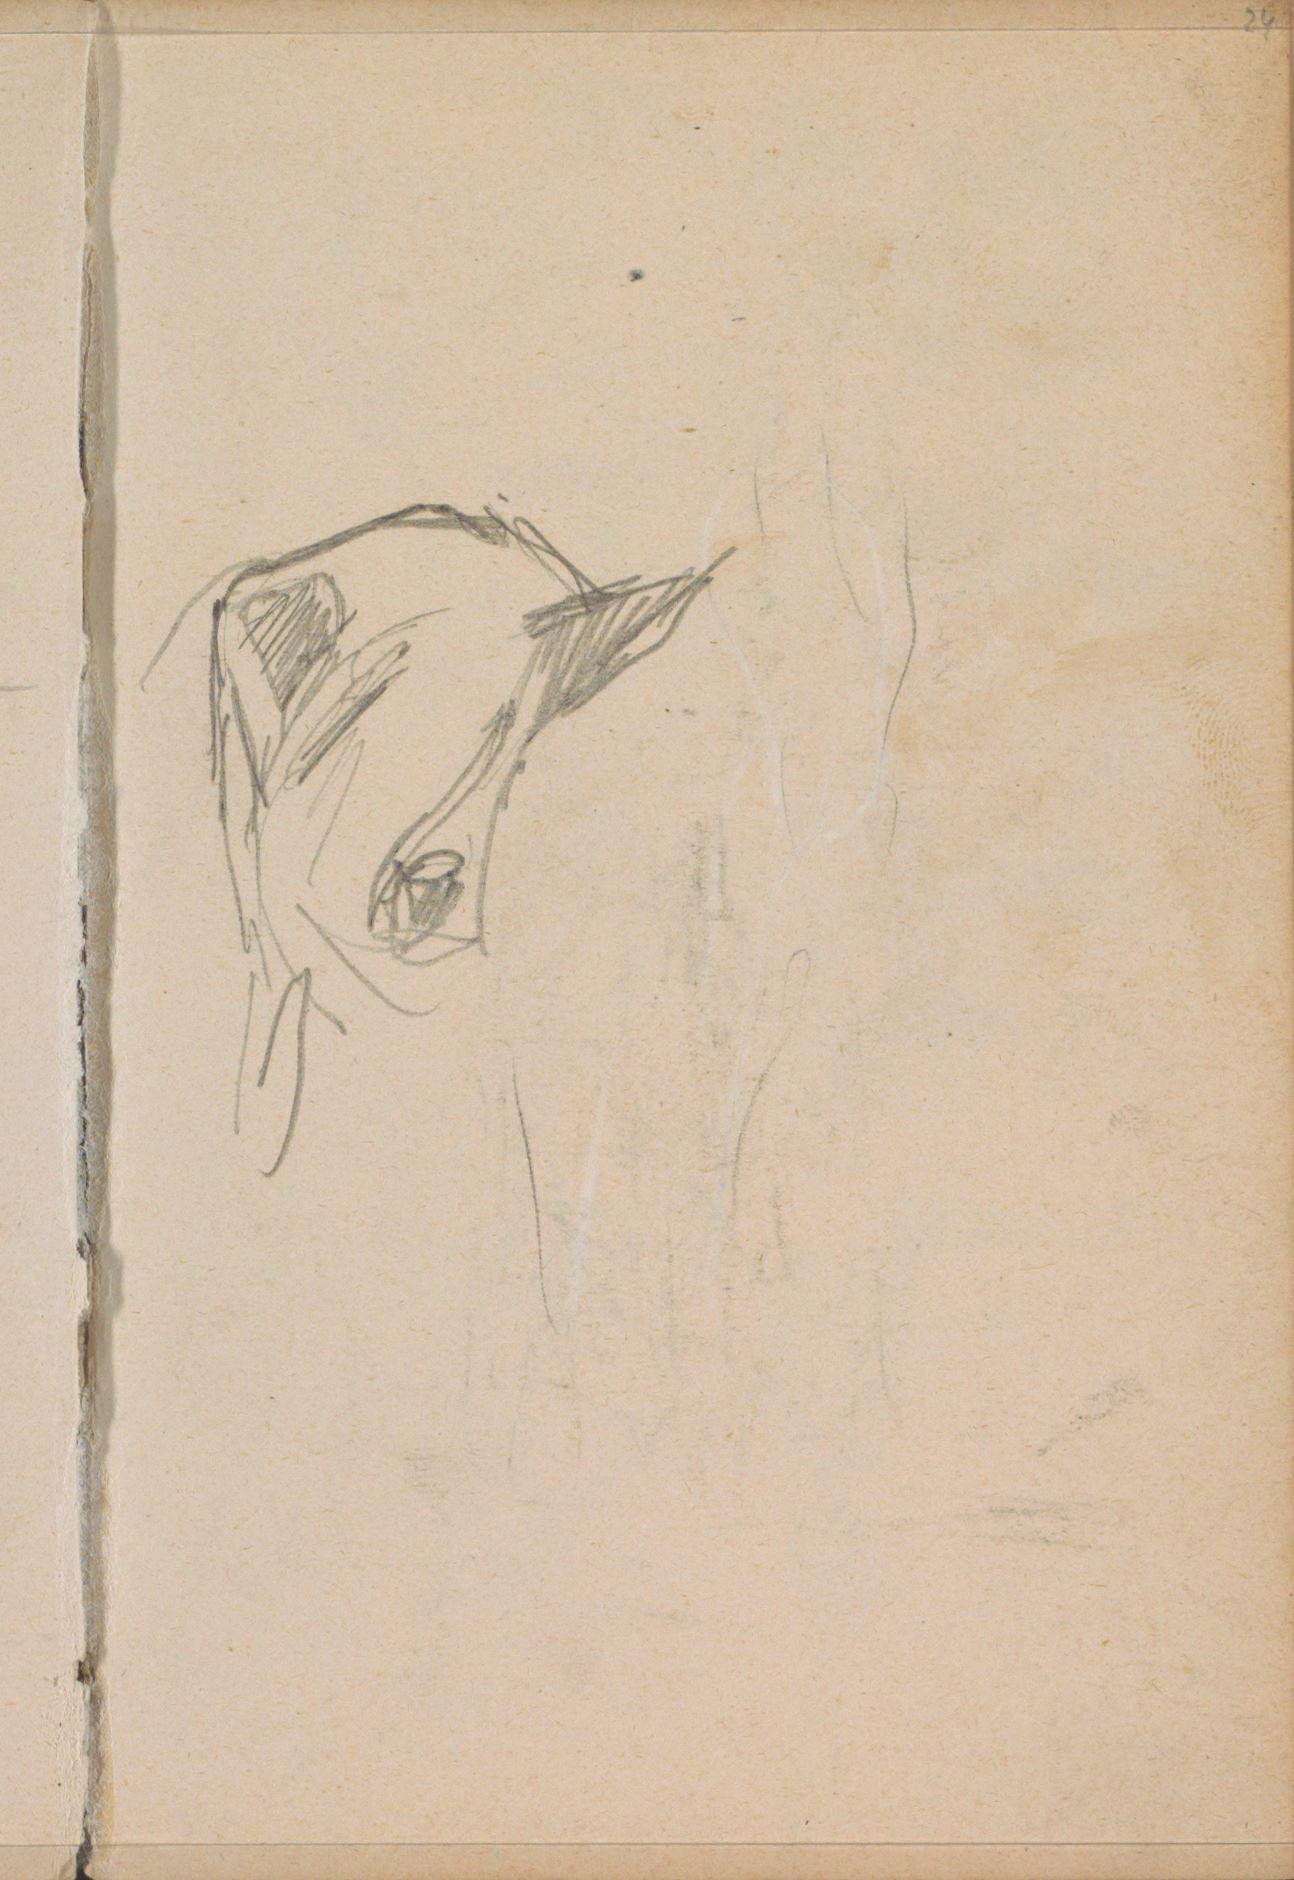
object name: sketchbook leaf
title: Studie, mogelijk van een paardenhoofd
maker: george hendrik breitner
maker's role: draughtsman, painter, print maker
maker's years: 1857-1923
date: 1902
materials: paper, pencil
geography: amsterdam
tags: horse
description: Pagina 24 uit een schetsboek met 46 bladen vervaardigd in de omgeving van Amsterdam, Rotterdam en Haarlem.